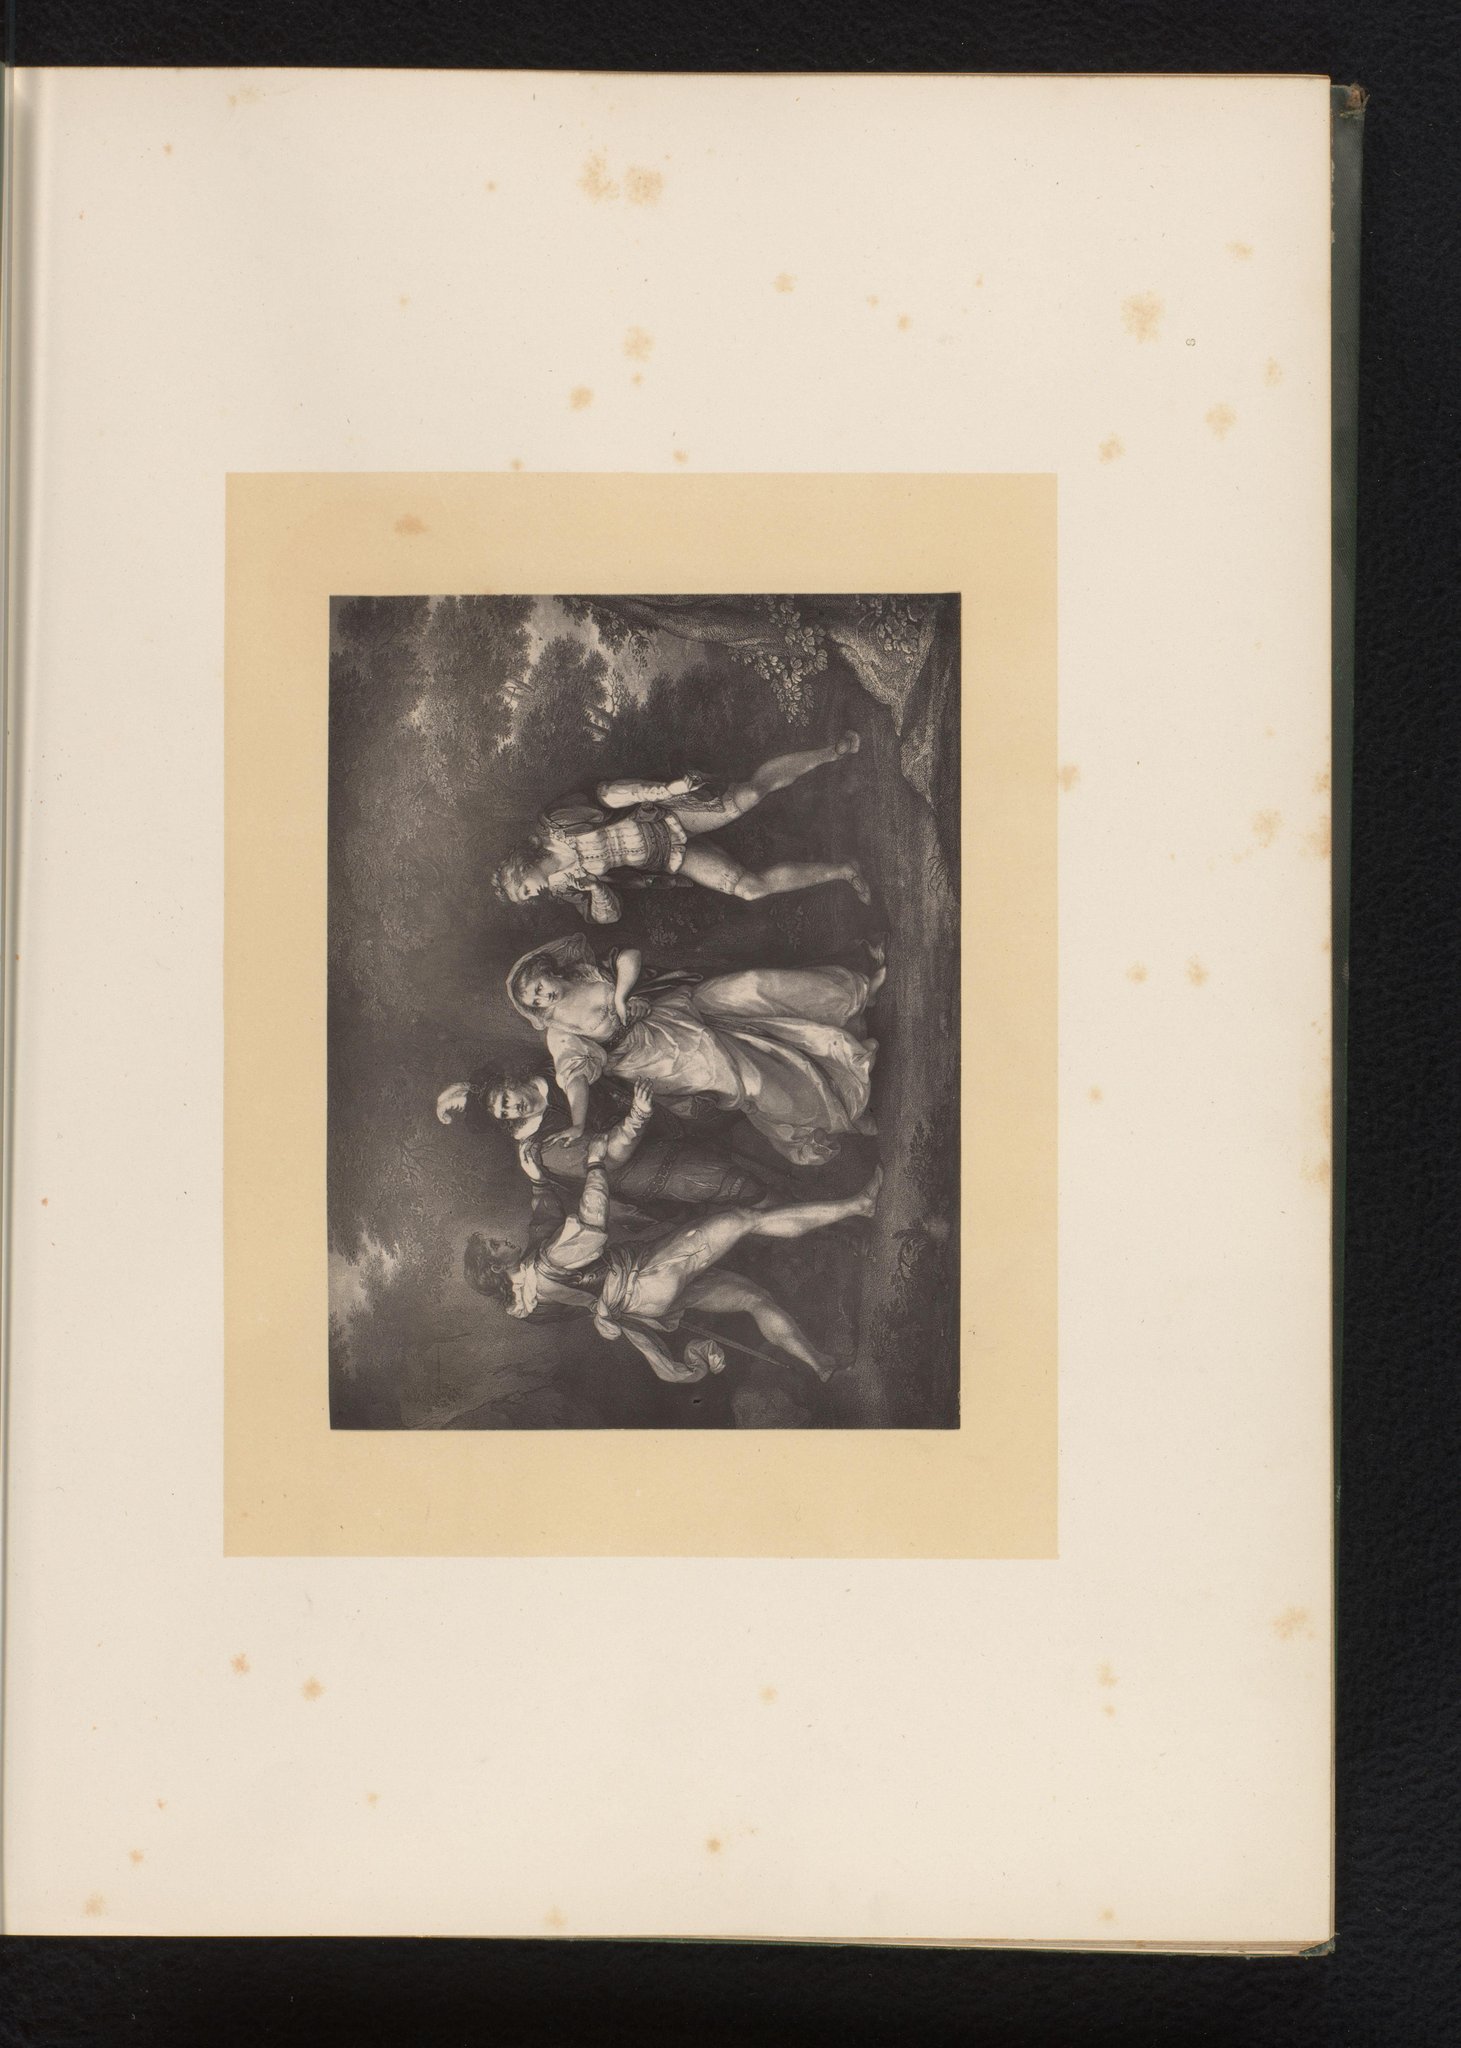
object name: photomechanical print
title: Reproductie van een reproductie naar een schilderij van een scène uit The Two Gentlemen of Verona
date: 1874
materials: paper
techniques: woodburytype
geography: london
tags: theatre, theatrical performance